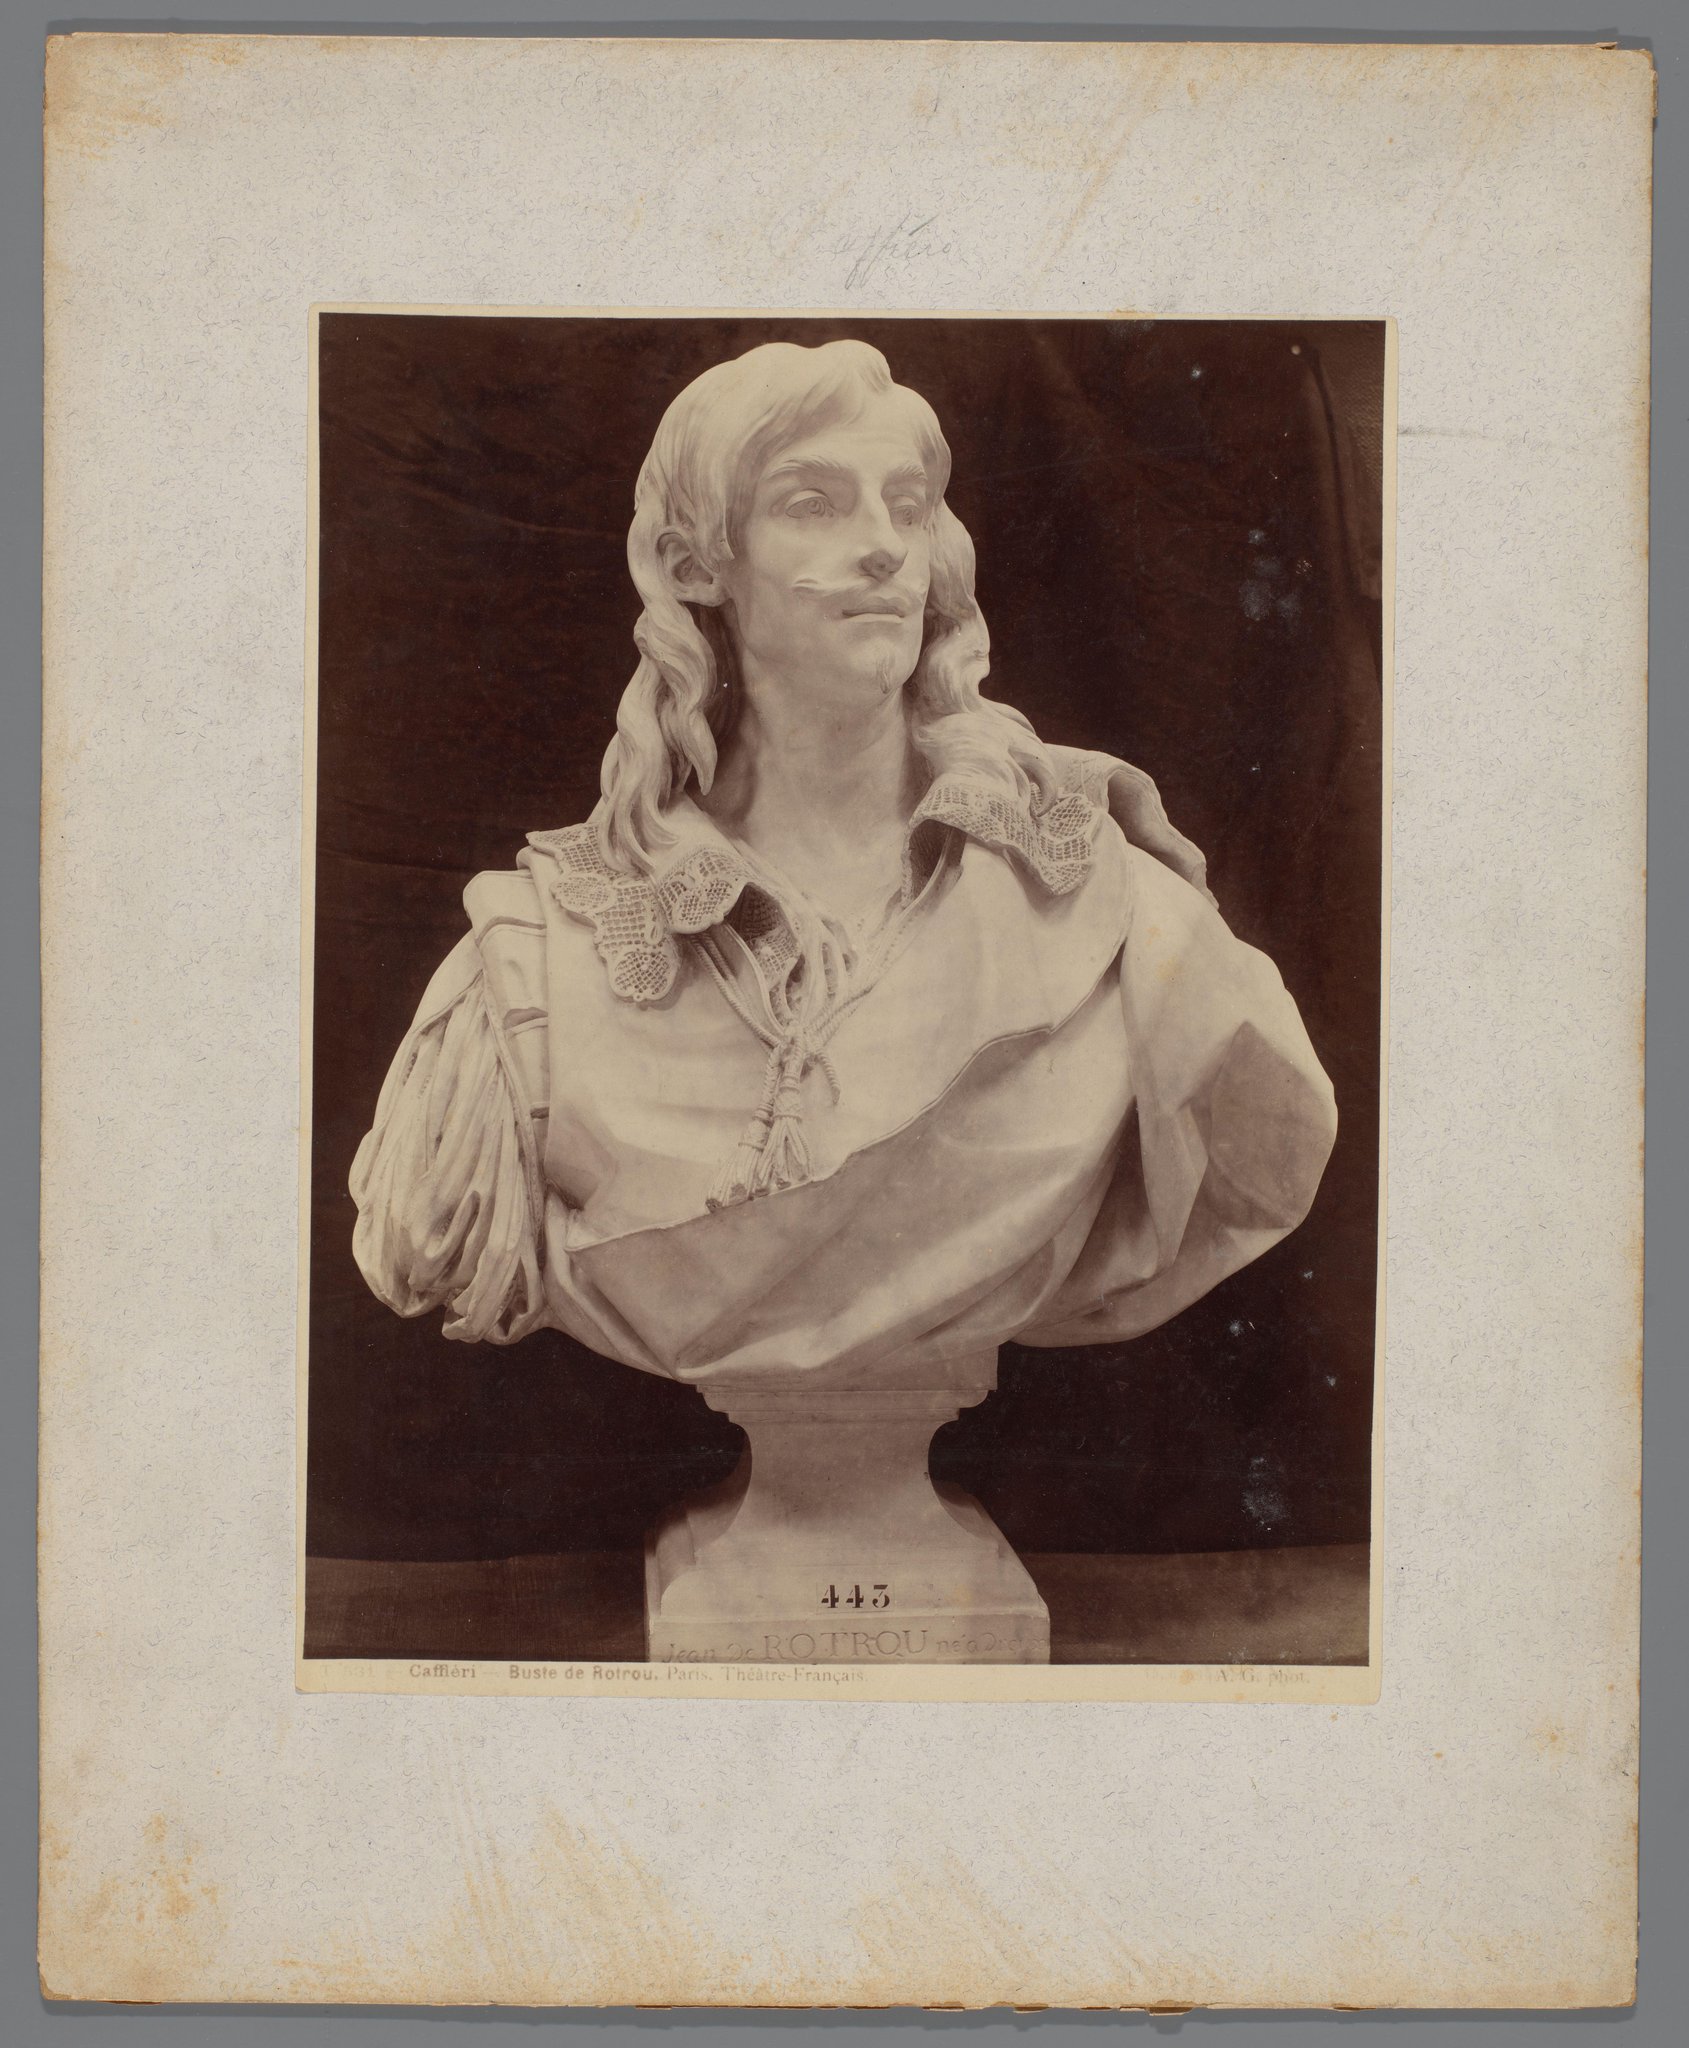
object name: photograph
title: Caffièri - Buste de Rotrou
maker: adolphe giraudon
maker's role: publisher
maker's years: 1849-1929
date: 1850-1900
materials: cardboard, photographic support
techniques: albumen print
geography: paris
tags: monument, statue, sculpture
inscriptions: annotation: ‘Caffiéri’, collector's mark: ‘RIJKS-NORMAALSCHOOL voor TEEKENONDERWIJZERS. AMSTERDAM’, inscription: ‘A.G. phot.’, number: ‘T 531’, inscription: ‘Paris. Théatre-Français.’, workshop stamp: ‘A. Giraudon/ Éditeur/ 15. R. Bonaparte. Paris’